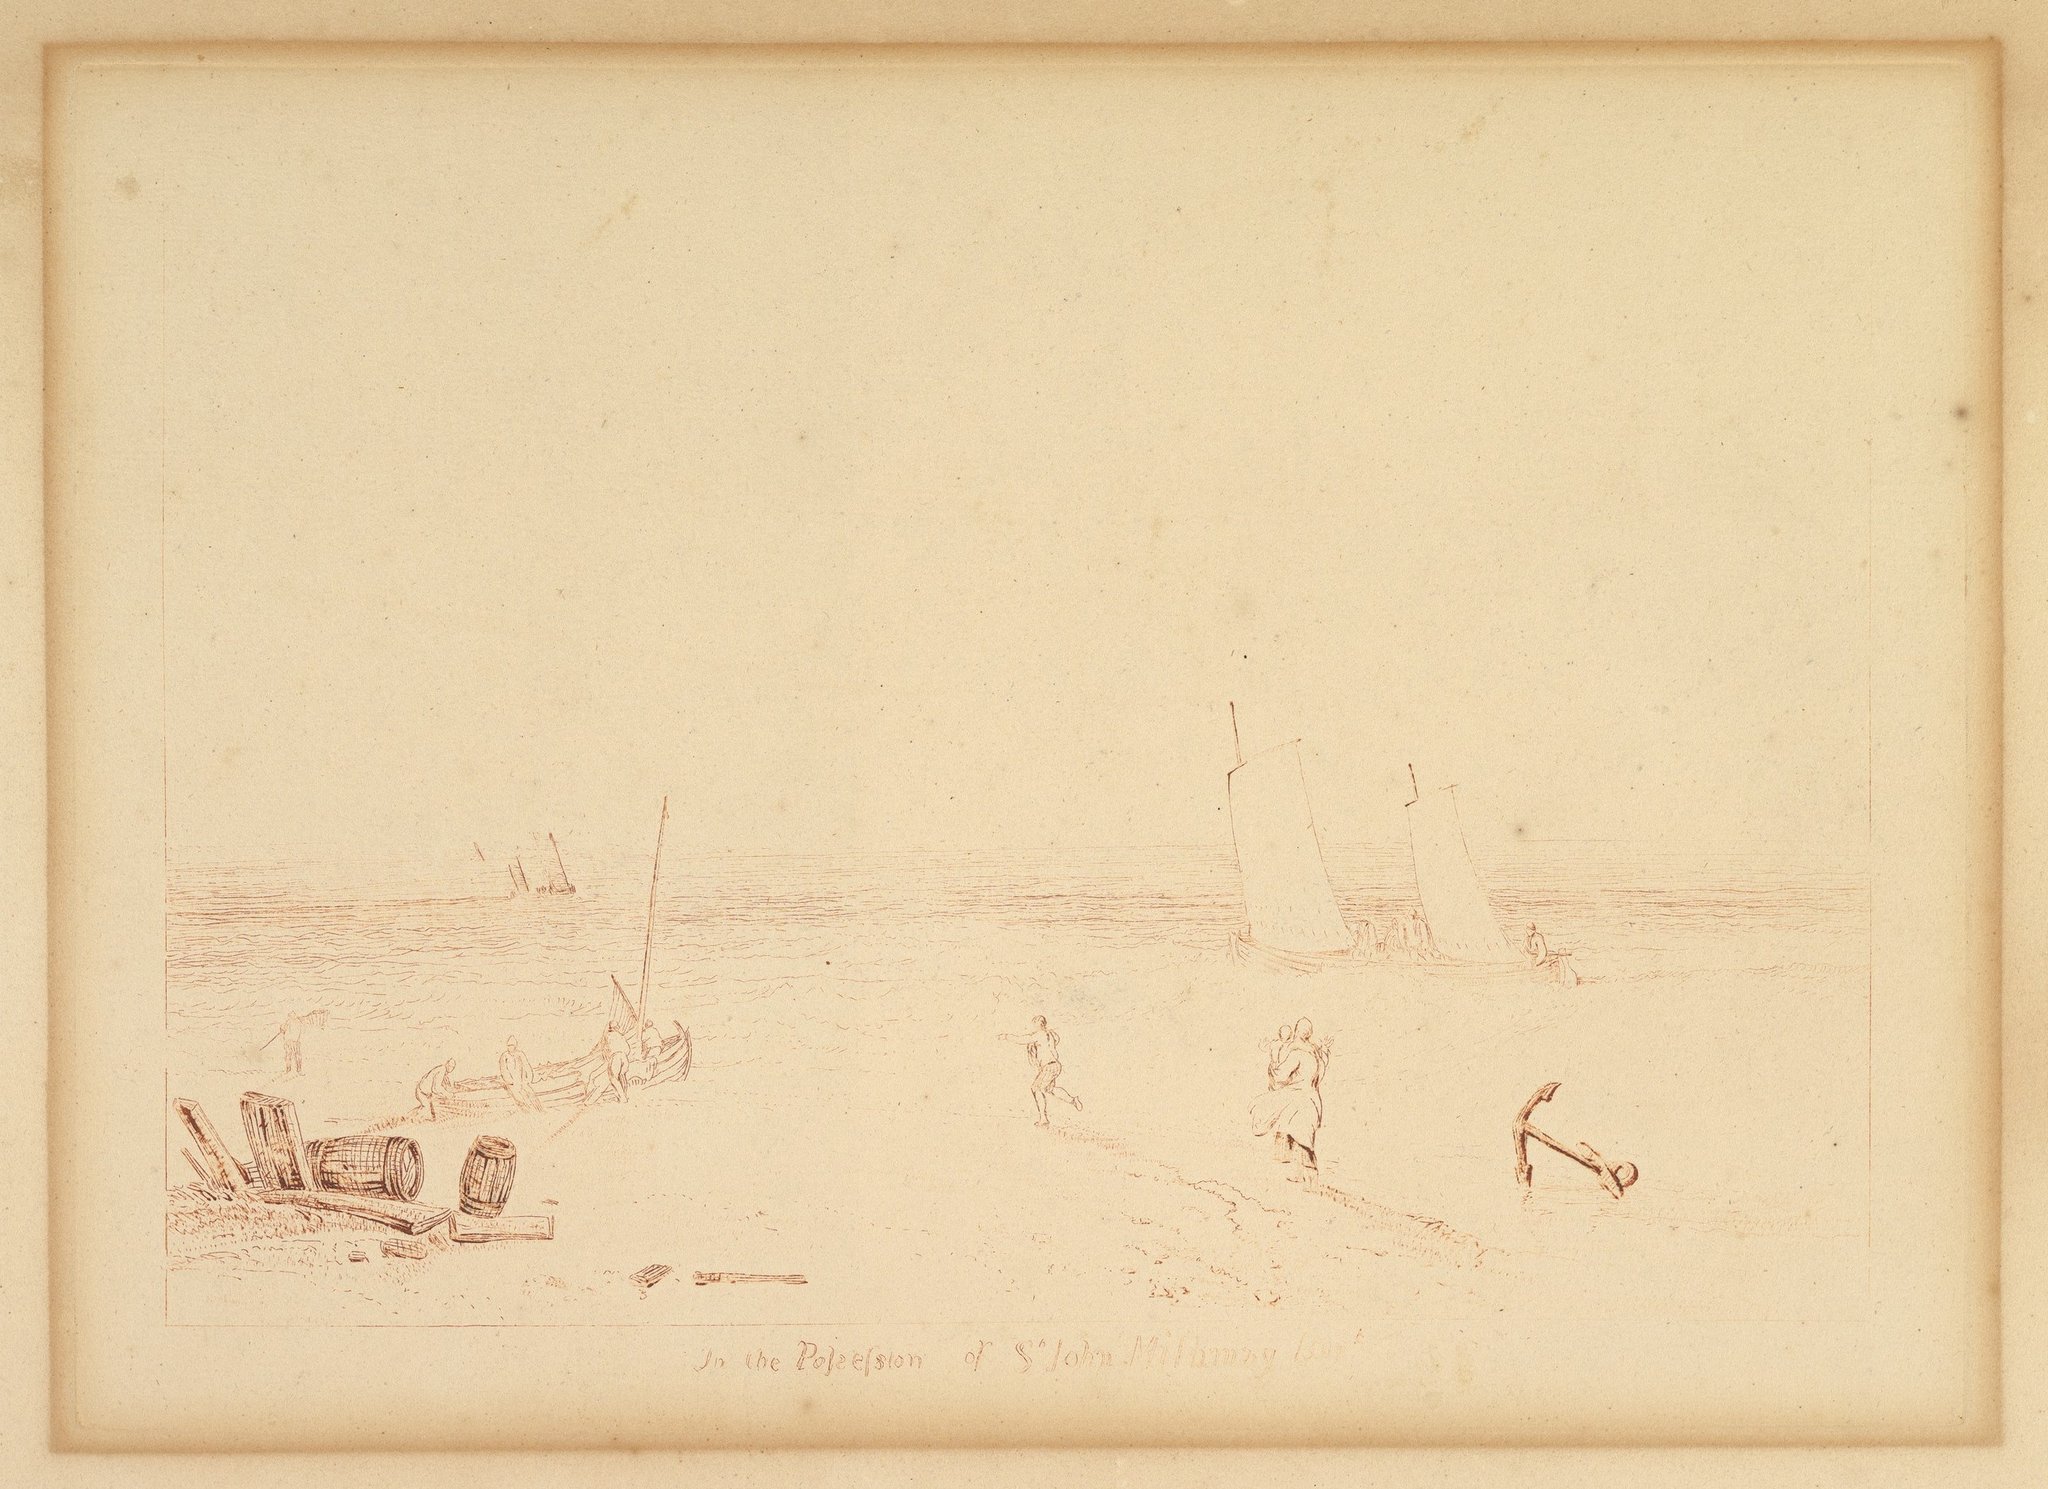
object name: print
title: The Mildmay Sea-Piece (Liber Studiorum, part XIII, plate 40)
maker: joseph mallord william turner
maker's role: artist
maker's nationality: british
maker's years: 1775-1851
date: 1812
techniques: etching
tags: human figures,boats